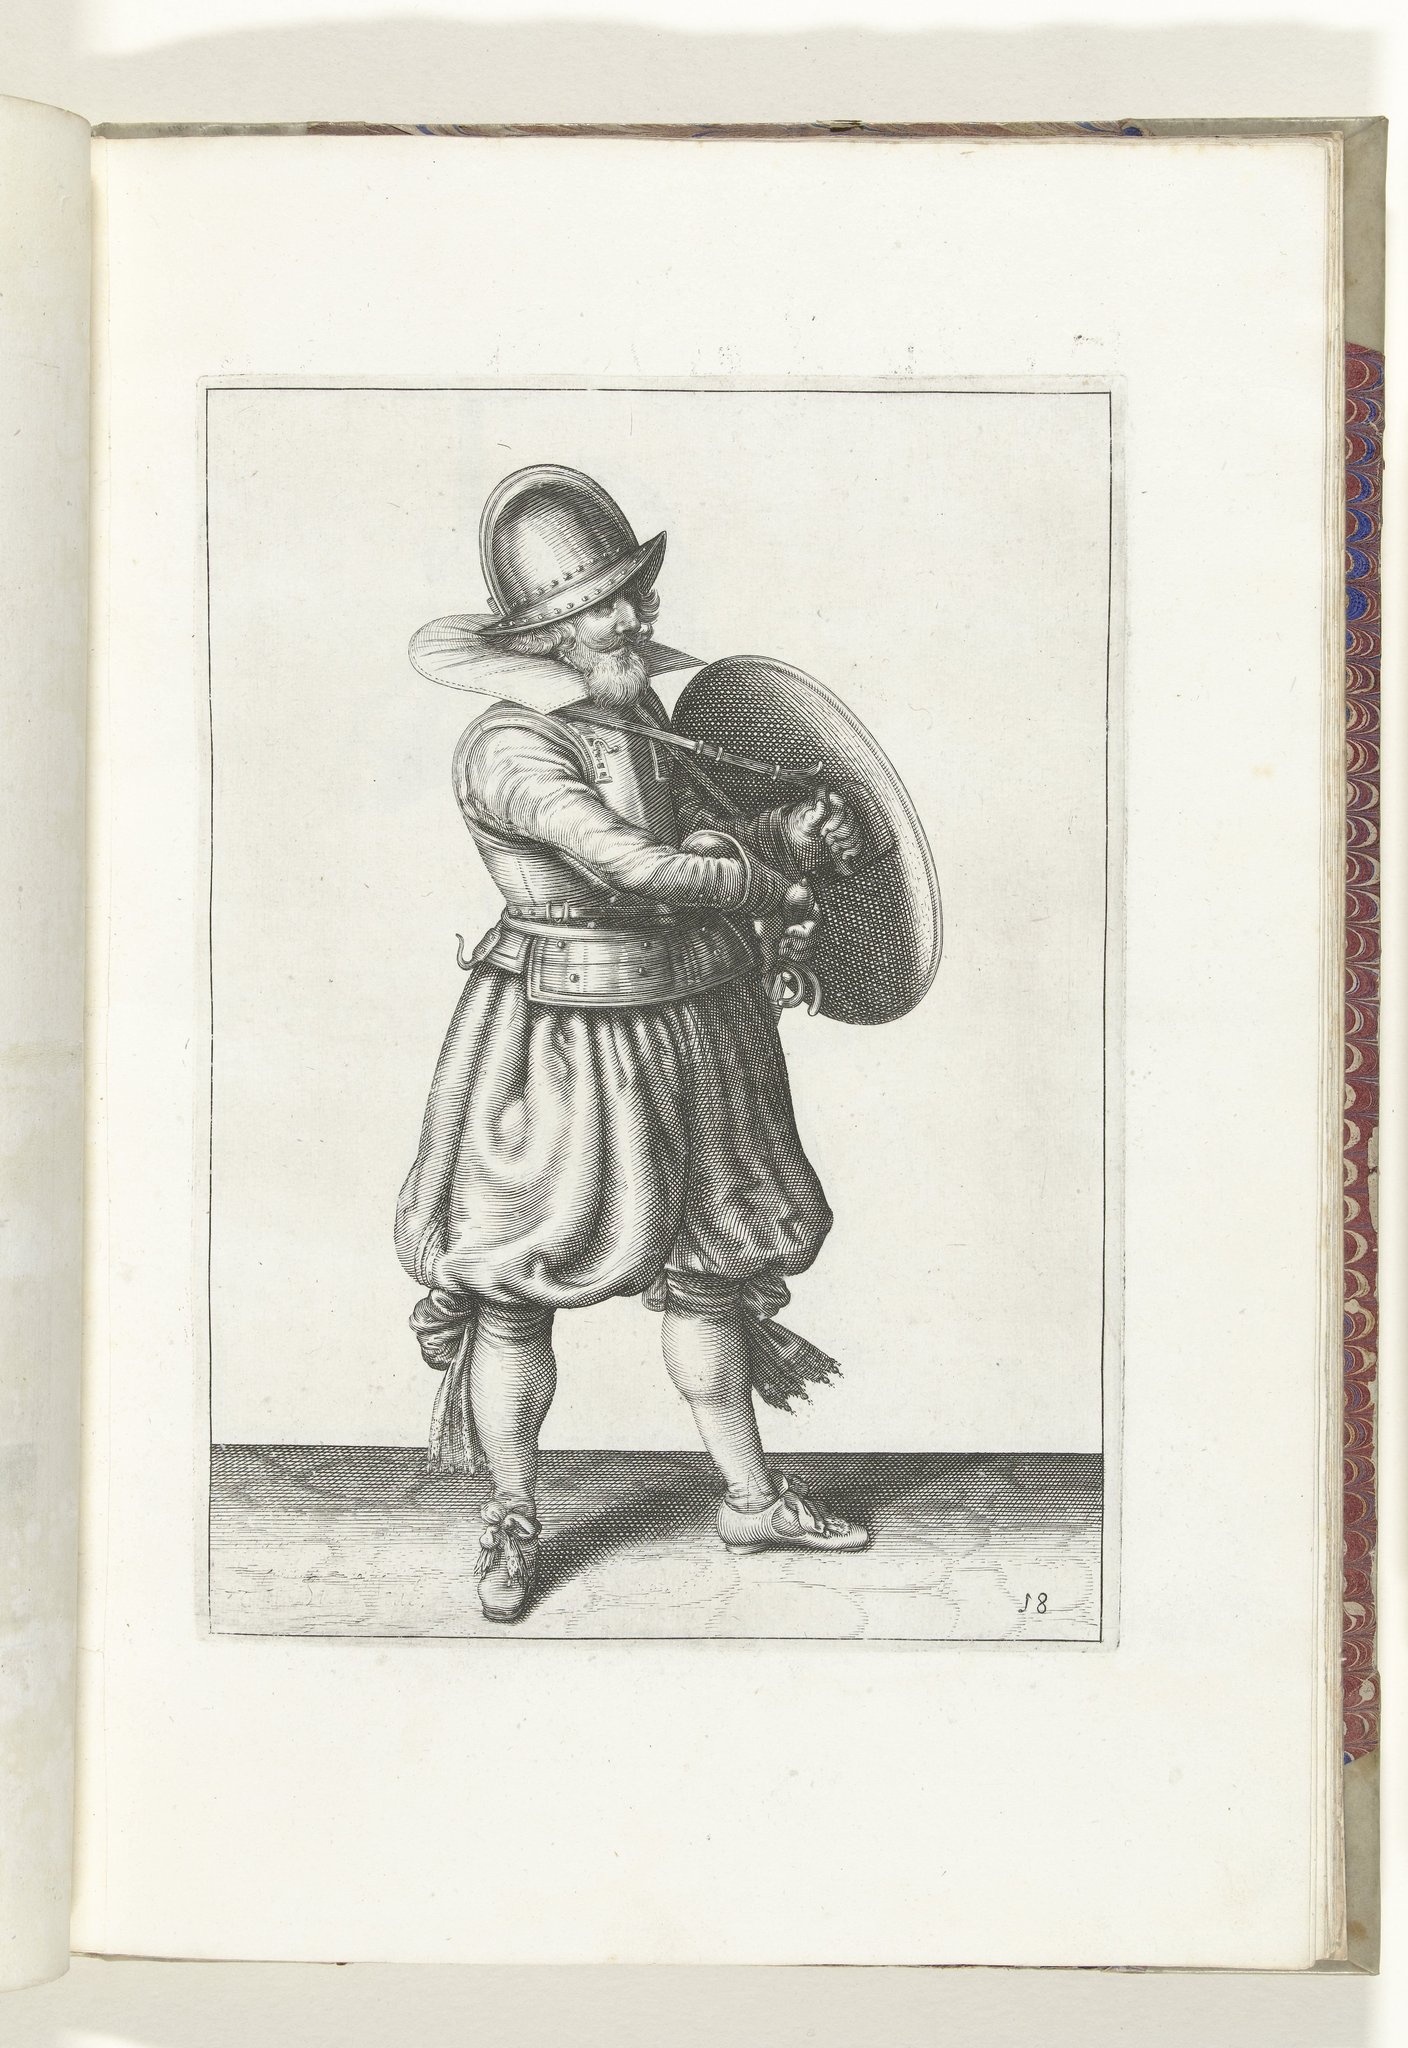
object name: print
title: De exercitie met schild en spies: de soldaat trekt zijn rapier van achter zijn schild (nr. 18), 1618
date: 1616-1618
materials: paper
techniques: engraving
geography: the hague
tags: maurice (prince of orange), handling of weapons ~ military training, weapons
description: Illustratie in: Adam van Breen, De Nassausche Wapen-Handelinge, van Schilt, Spies, Rappier ende Targe : beyde figuerlick afgebeelt, ende gestelt na de nieu ordening [van] ... Maurits van Nassau, 's-Gravenhage, [Aert Meuris] 1618, plaat nr. 18. In het exemplaar in de collectie van de Rijksmuseum Research Library (326 F 22).